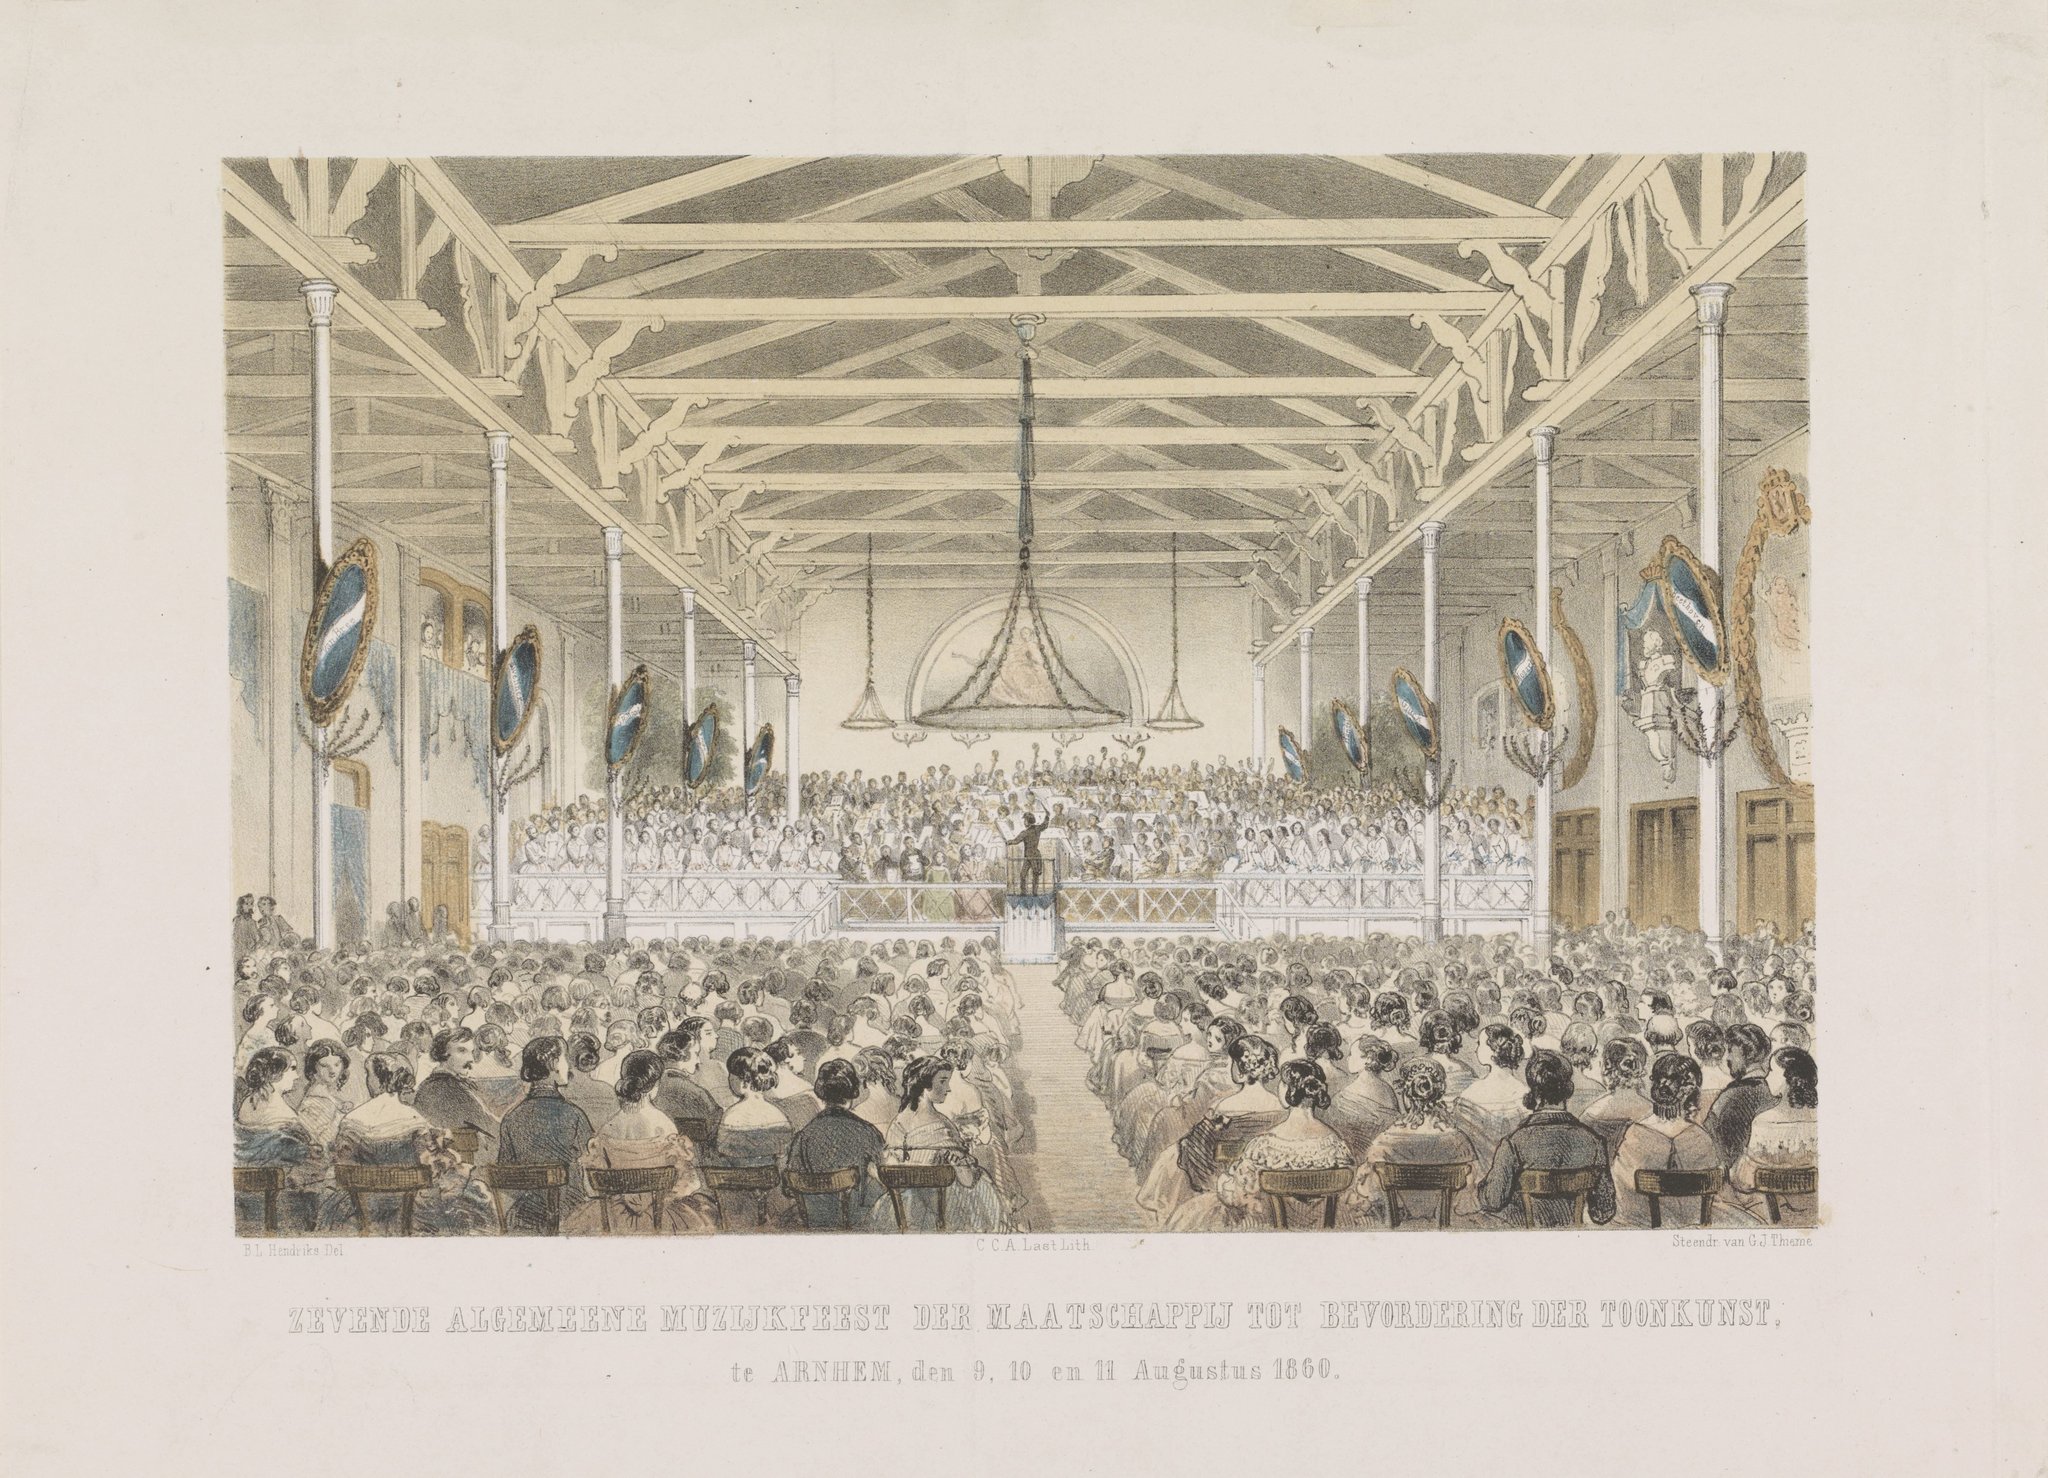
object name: print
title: Zevende Algemeene Muzijkfeest der Maatschappij tot Bevordering der Toonkunst, te Arnhem, den 9, 10 en 11 Augustus 1860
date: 1860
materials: paper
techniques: lithograph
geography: netherlands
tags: large group of musicians, orchestra, choir, concert hall, arnhem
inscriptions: collector's mark: Lugt 2228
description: Gezicht in de grote concertzaal van Musis Sacrum tijdens de Zevende Algemene Muziekfeest georganiseerd door de Maatschappij tot Bevordering der Toonkunst, te Arnhem 9-11 augustus 1860.